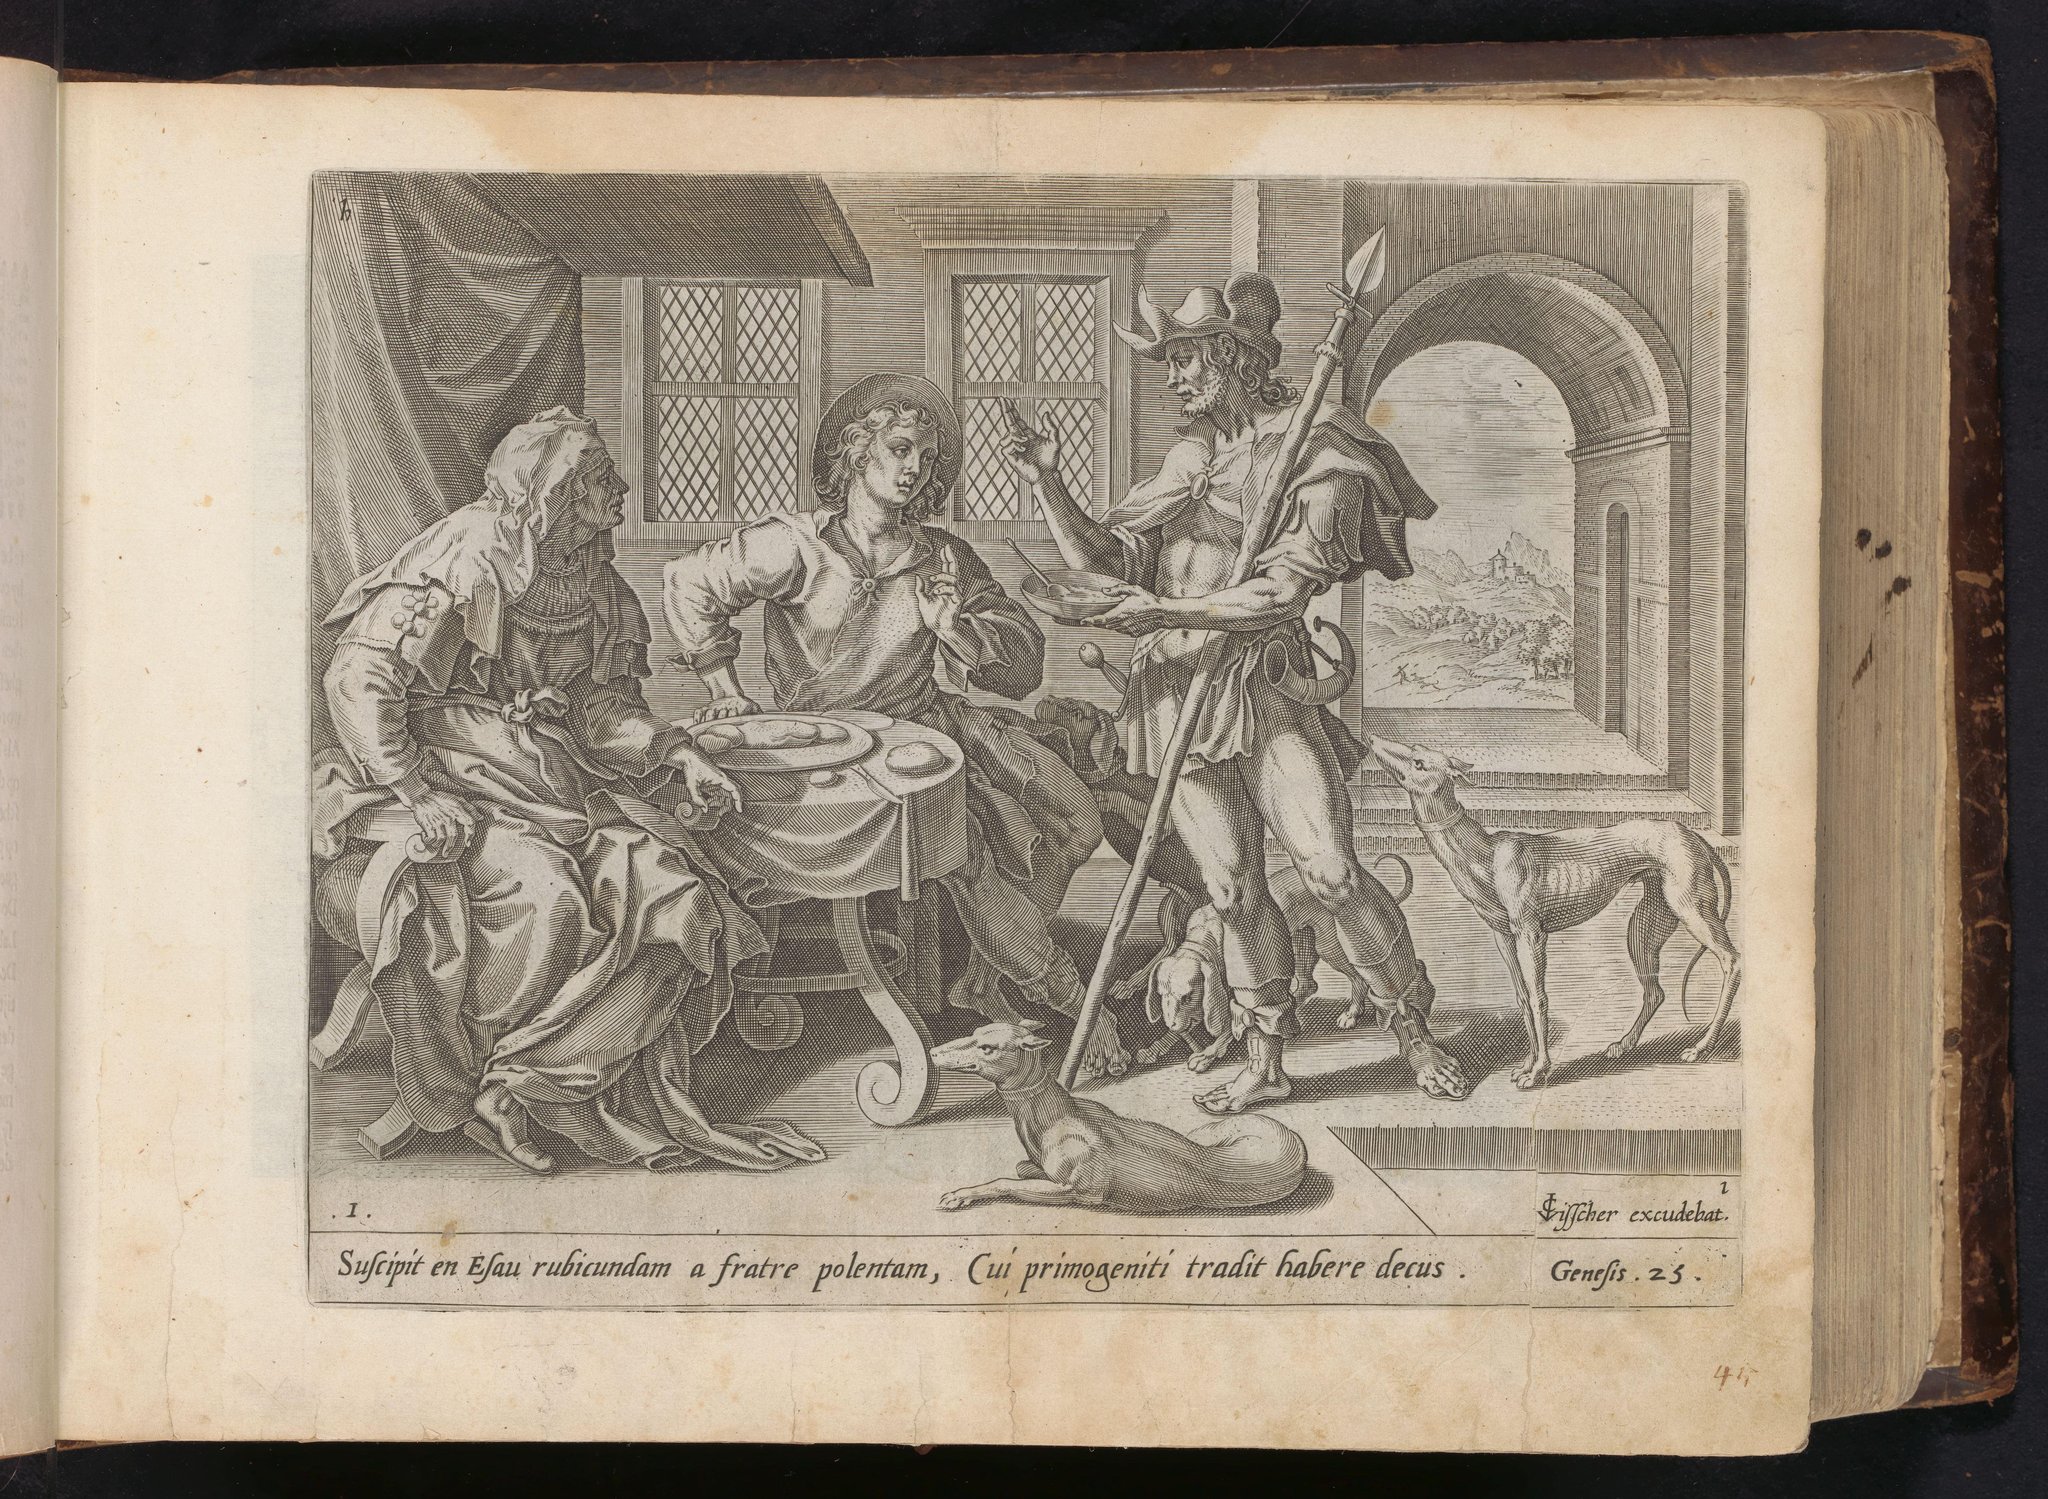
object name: print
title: Van Iacob en Esau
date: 1579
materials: paper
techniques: engraving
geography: amsterdam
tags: esau, returning hungry from the hunt, sells his first birthright to jacob for a pottage of lentils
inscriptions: number: ‘45’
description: Esau is hongerig teruggekeerd van de jacht. Zijn jachthonden staan naast hem. Hij verkoopt zijn eerstgeboorterecht aan zijn jongere broer Jakob voor een bord linzen, dat hij al in zijn handen heeft. Jakob en Rebekka zitten aan tafel. Onder de voorstelling een verwijzing in het Latijn naar de Bijbeltekst in Gen. 25. Deze prent maakt deel uit van een album.